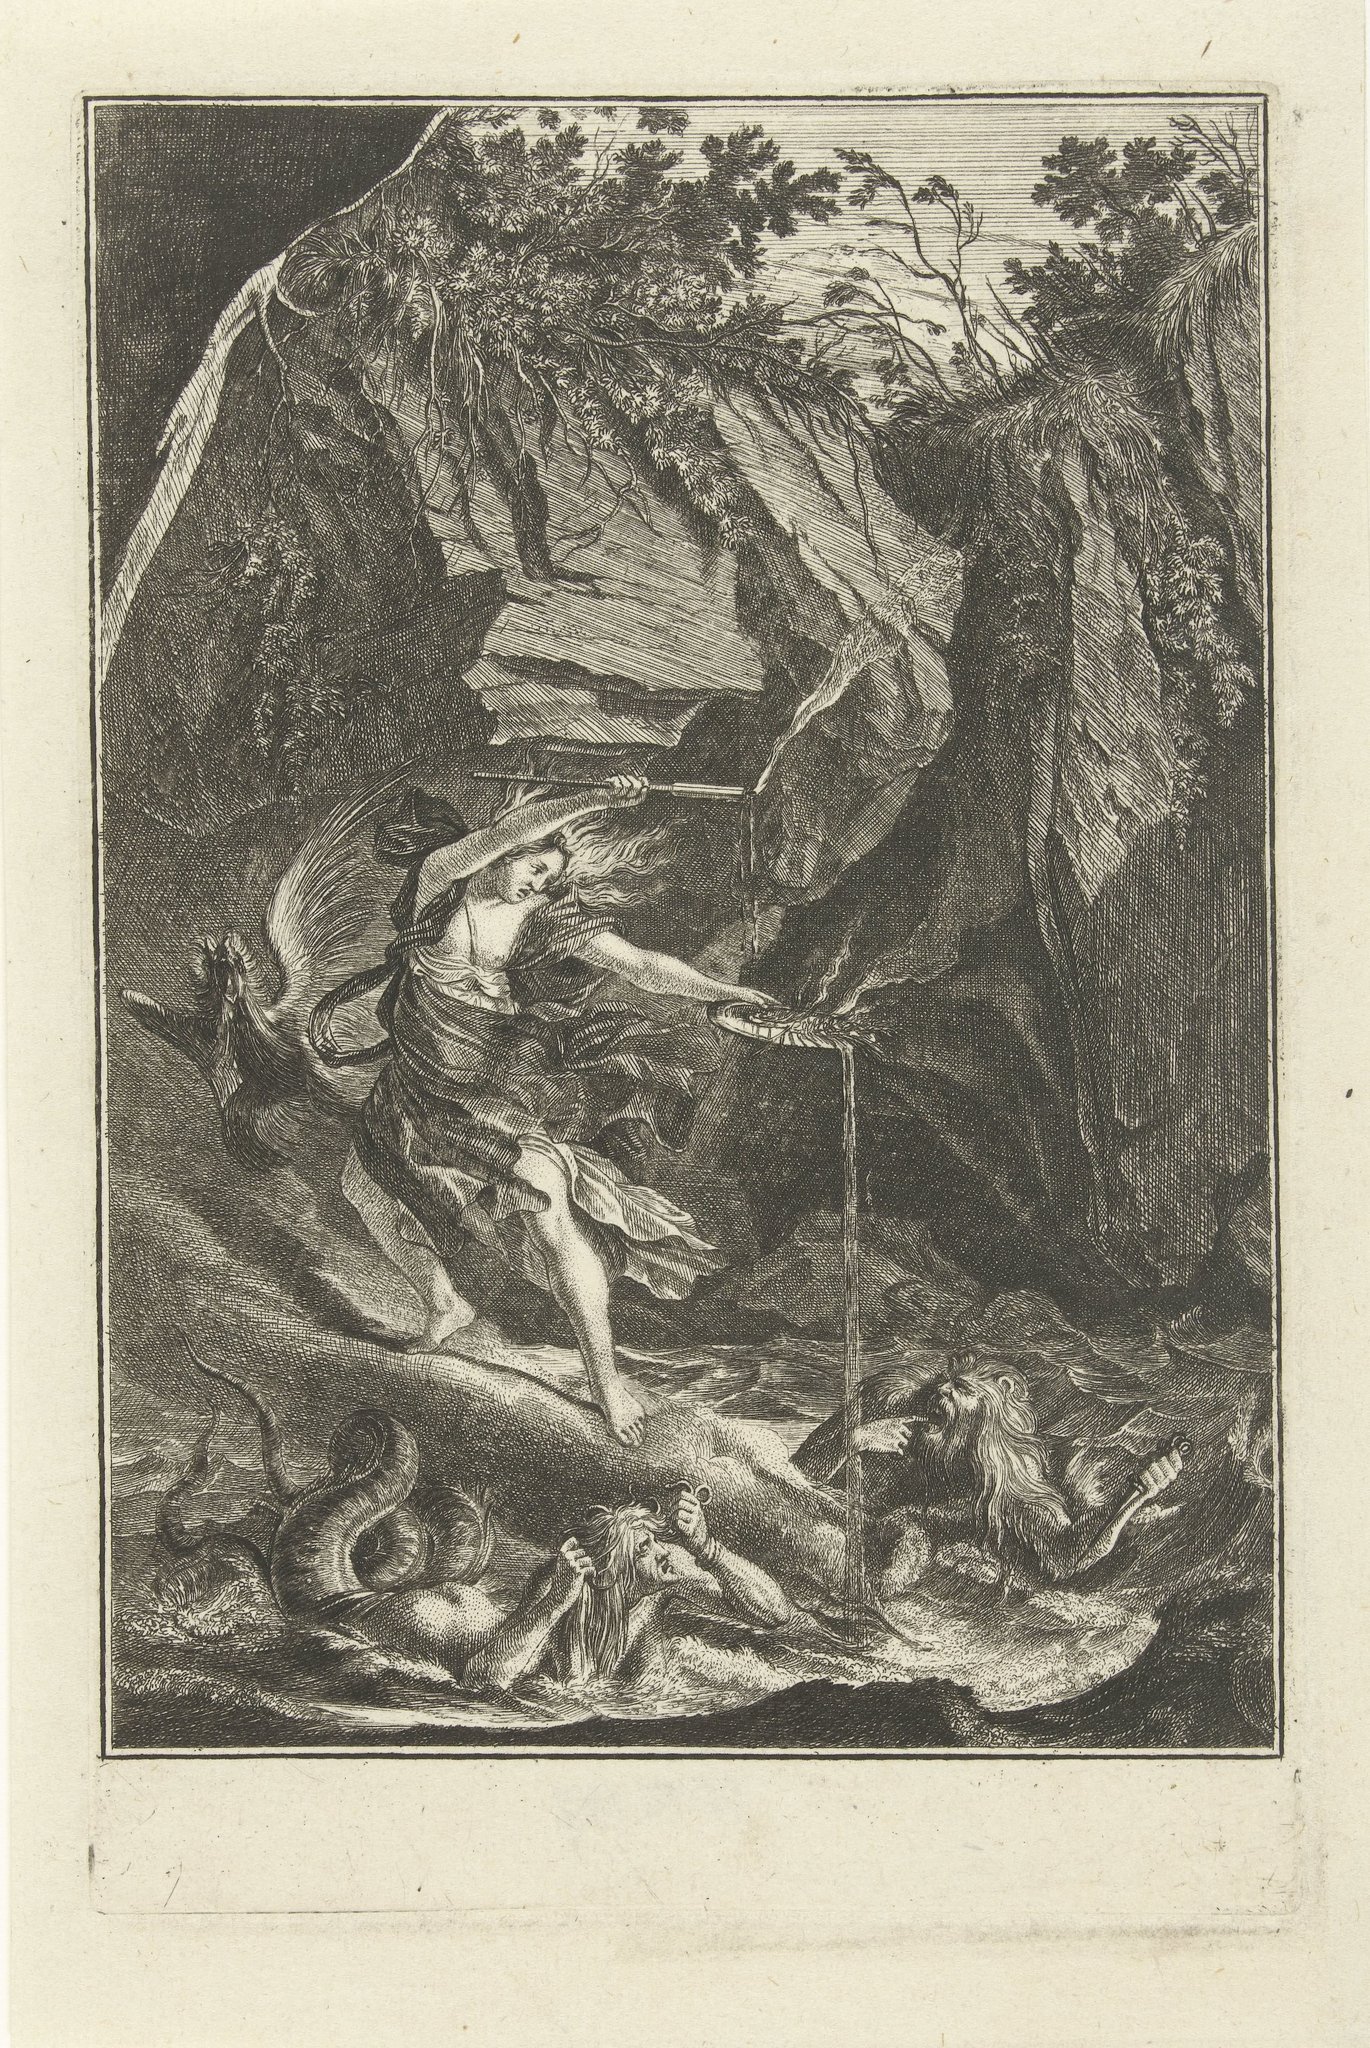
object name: print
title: Glaucus en Scylla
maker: franz ertinger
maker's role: print maker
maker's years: 1640-1710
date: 1650-1710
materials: paper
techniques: engraving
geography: paris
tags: scylla changed into a sea-monster: circe, to whom glaucus has applied for aid in his love suit, changes scylla the sea-nymph into a sea-monster (ovid, metamorphoses xiv 59)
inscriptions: collector's mark: Lugt 2228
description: De jaloerse tovenares Circe vergiftigt het water, zodat de badende nimf Scylla net als Glaucus, met dolk, in een zeemonster verandert.